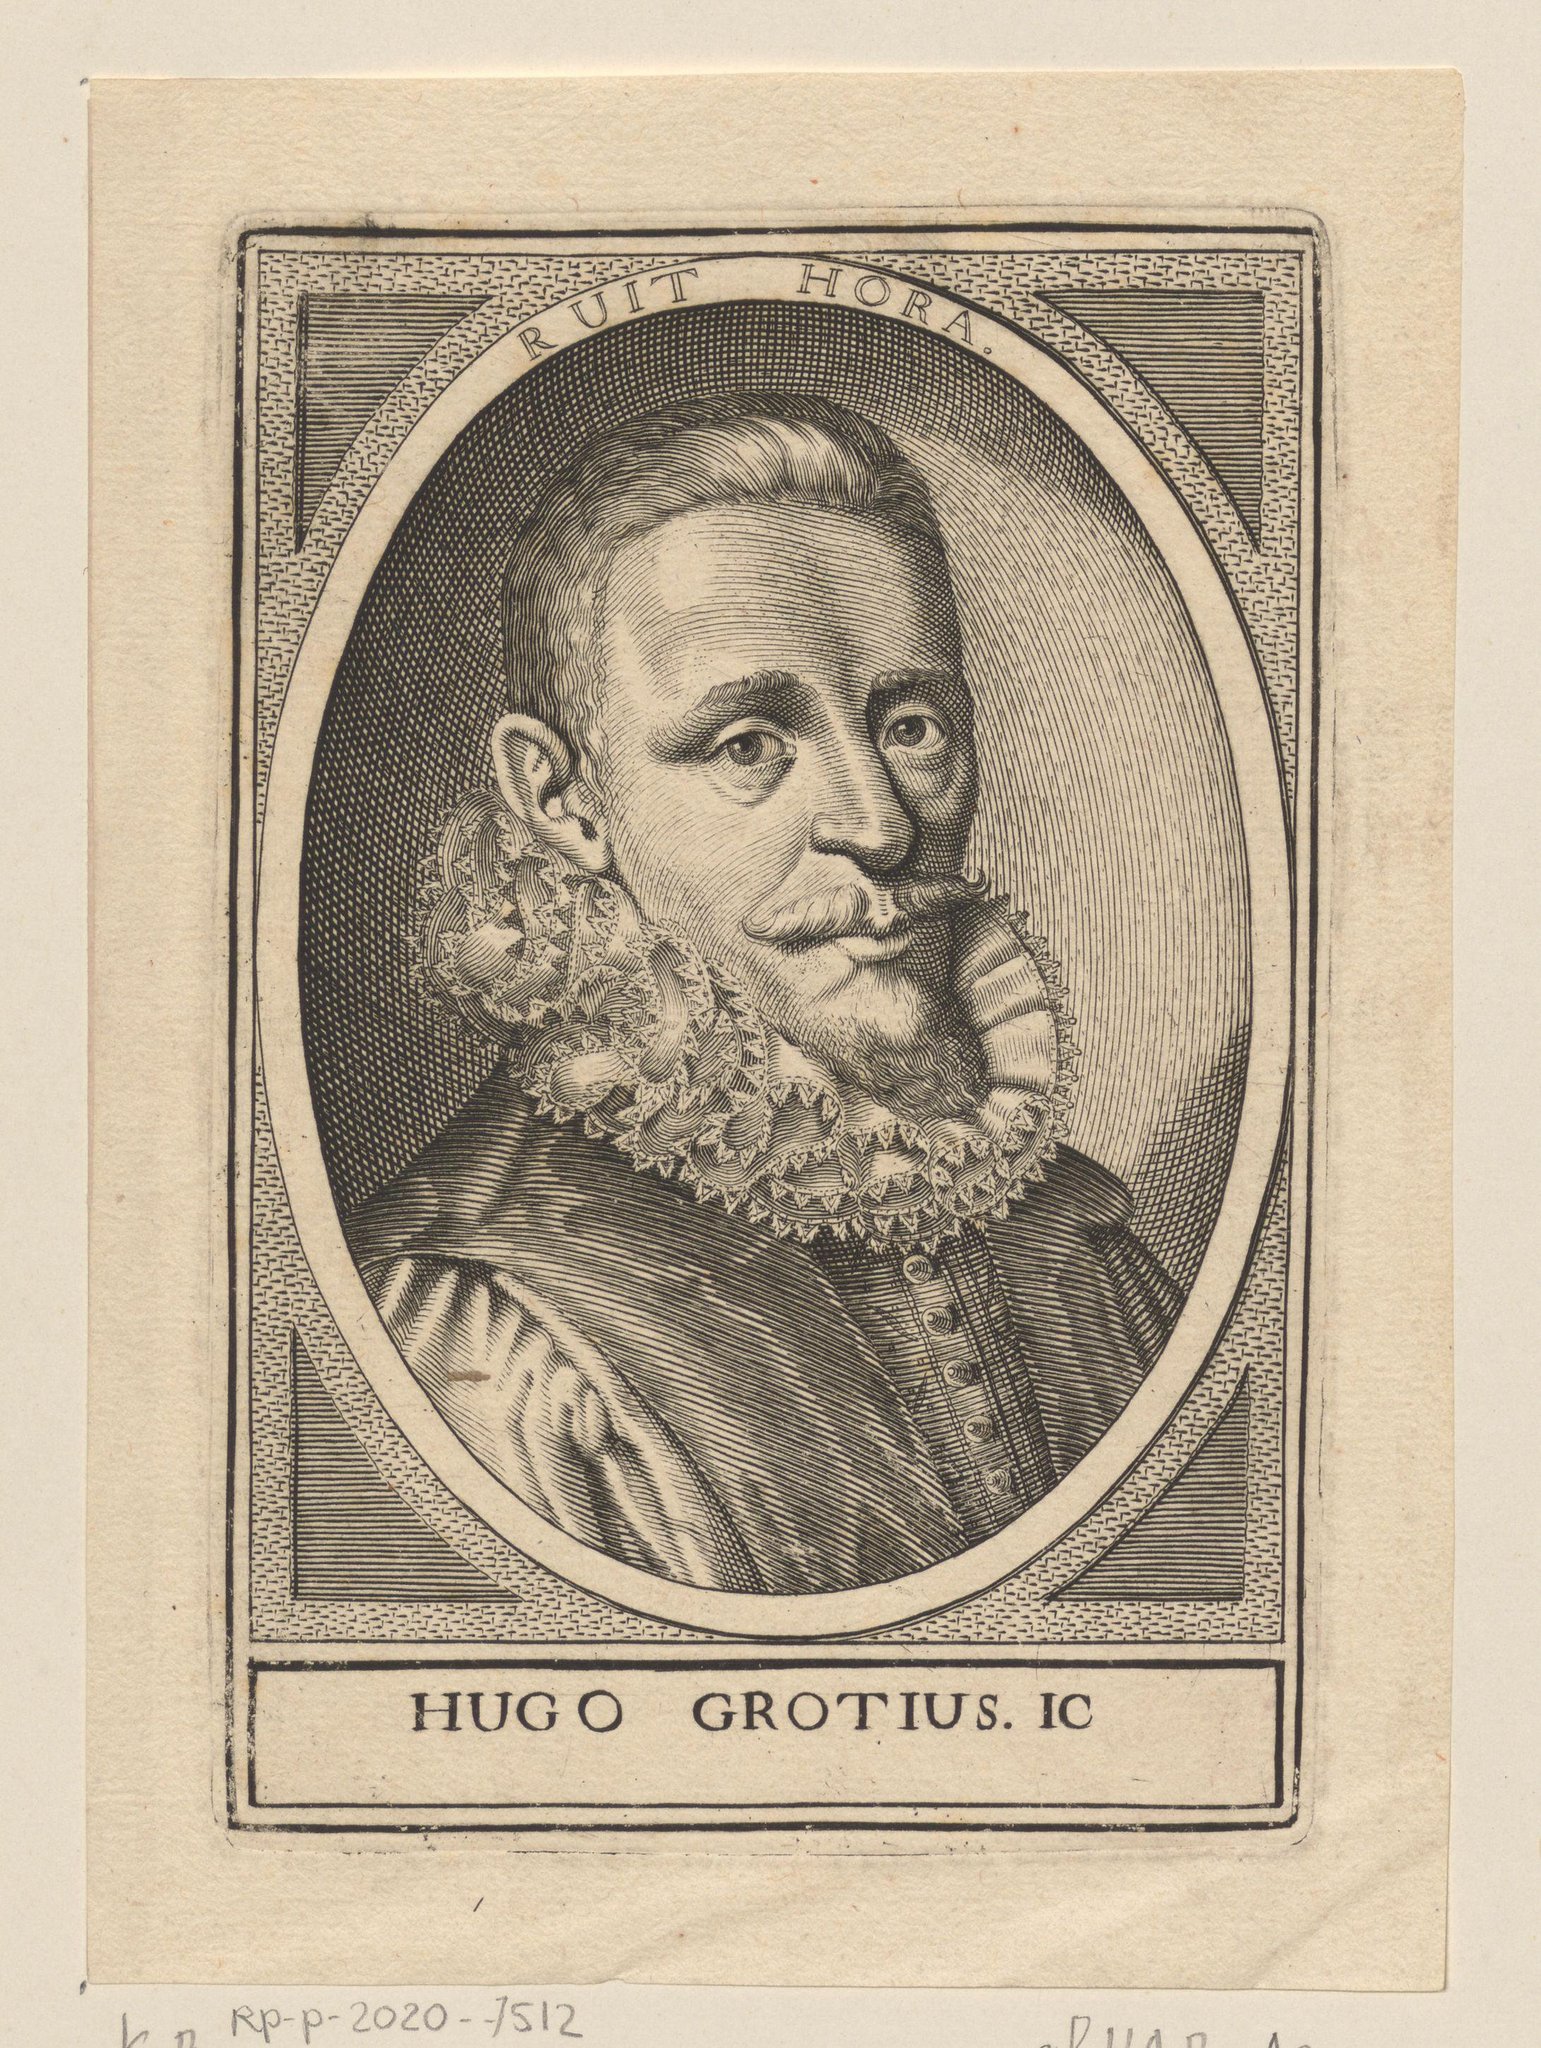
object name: print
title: Portret van Hugo de Groot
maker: Anonymous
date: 1614-1714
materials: paper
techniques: engraving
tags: delft, hugo de groot, historical persons, portrait of a writer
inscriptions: collector's mark: Lugt 240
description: Prent mogelijk uit: Meursius, Joannes. Illustrium Hollandiae & Westfrisiae ordinum alma academia Leidensis. Leiden: Jacob Marcus en Joost van Colster, 1614.